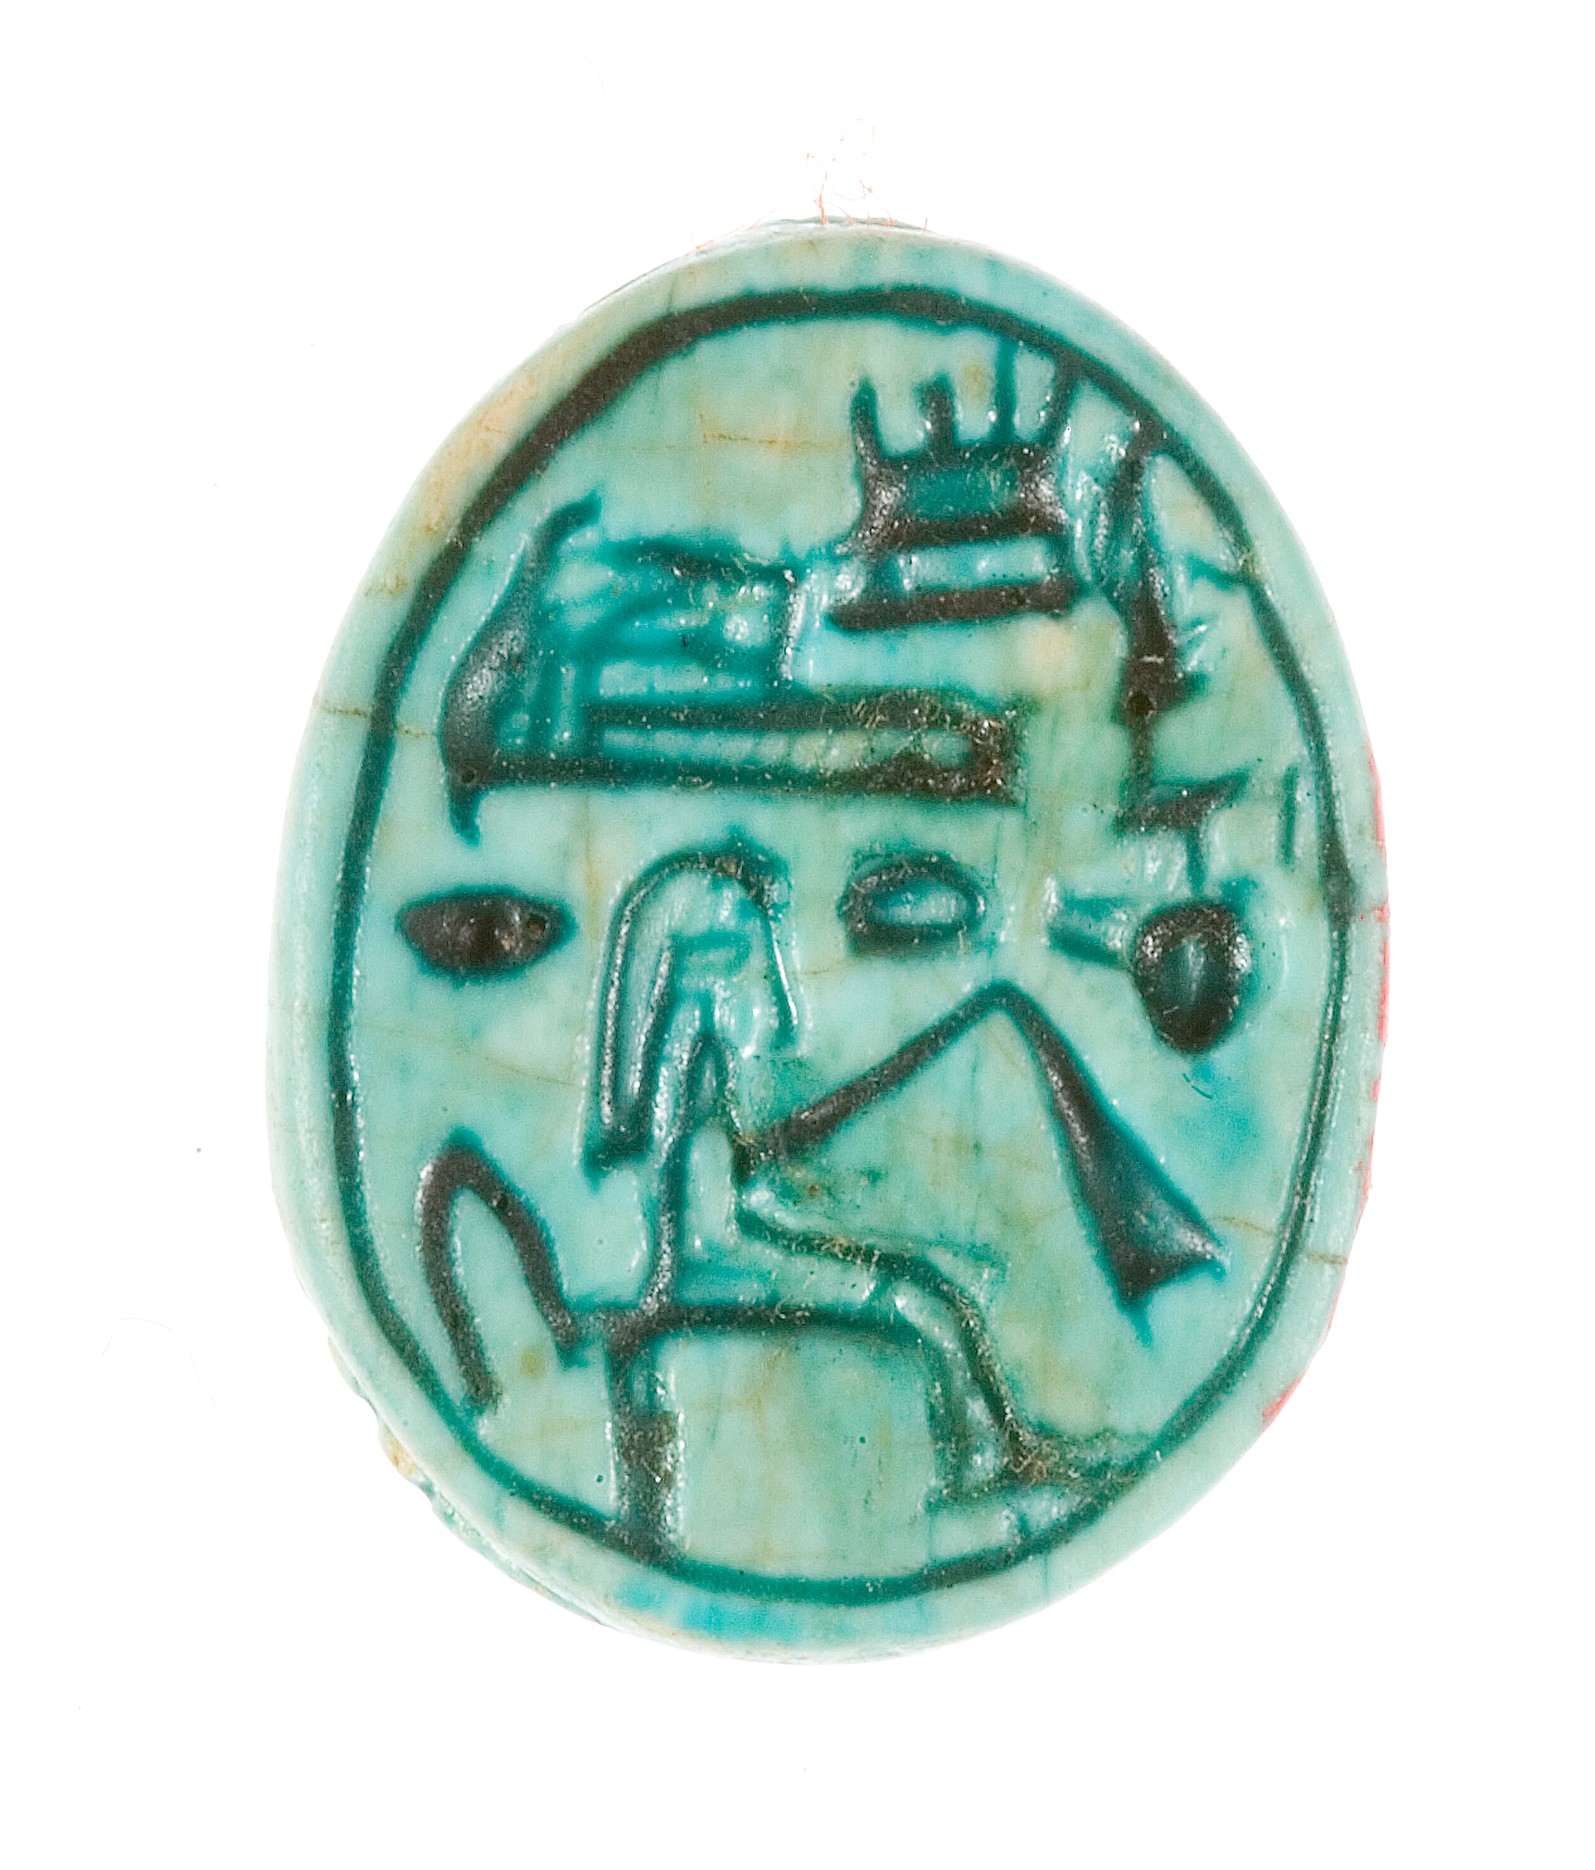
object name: scarab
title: Scarab Inscribed Hatshepsut United with Amun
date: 1479-1458 BCE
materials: stone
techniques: glazing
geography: egypt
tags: hieroglyphs,amun,scarabs